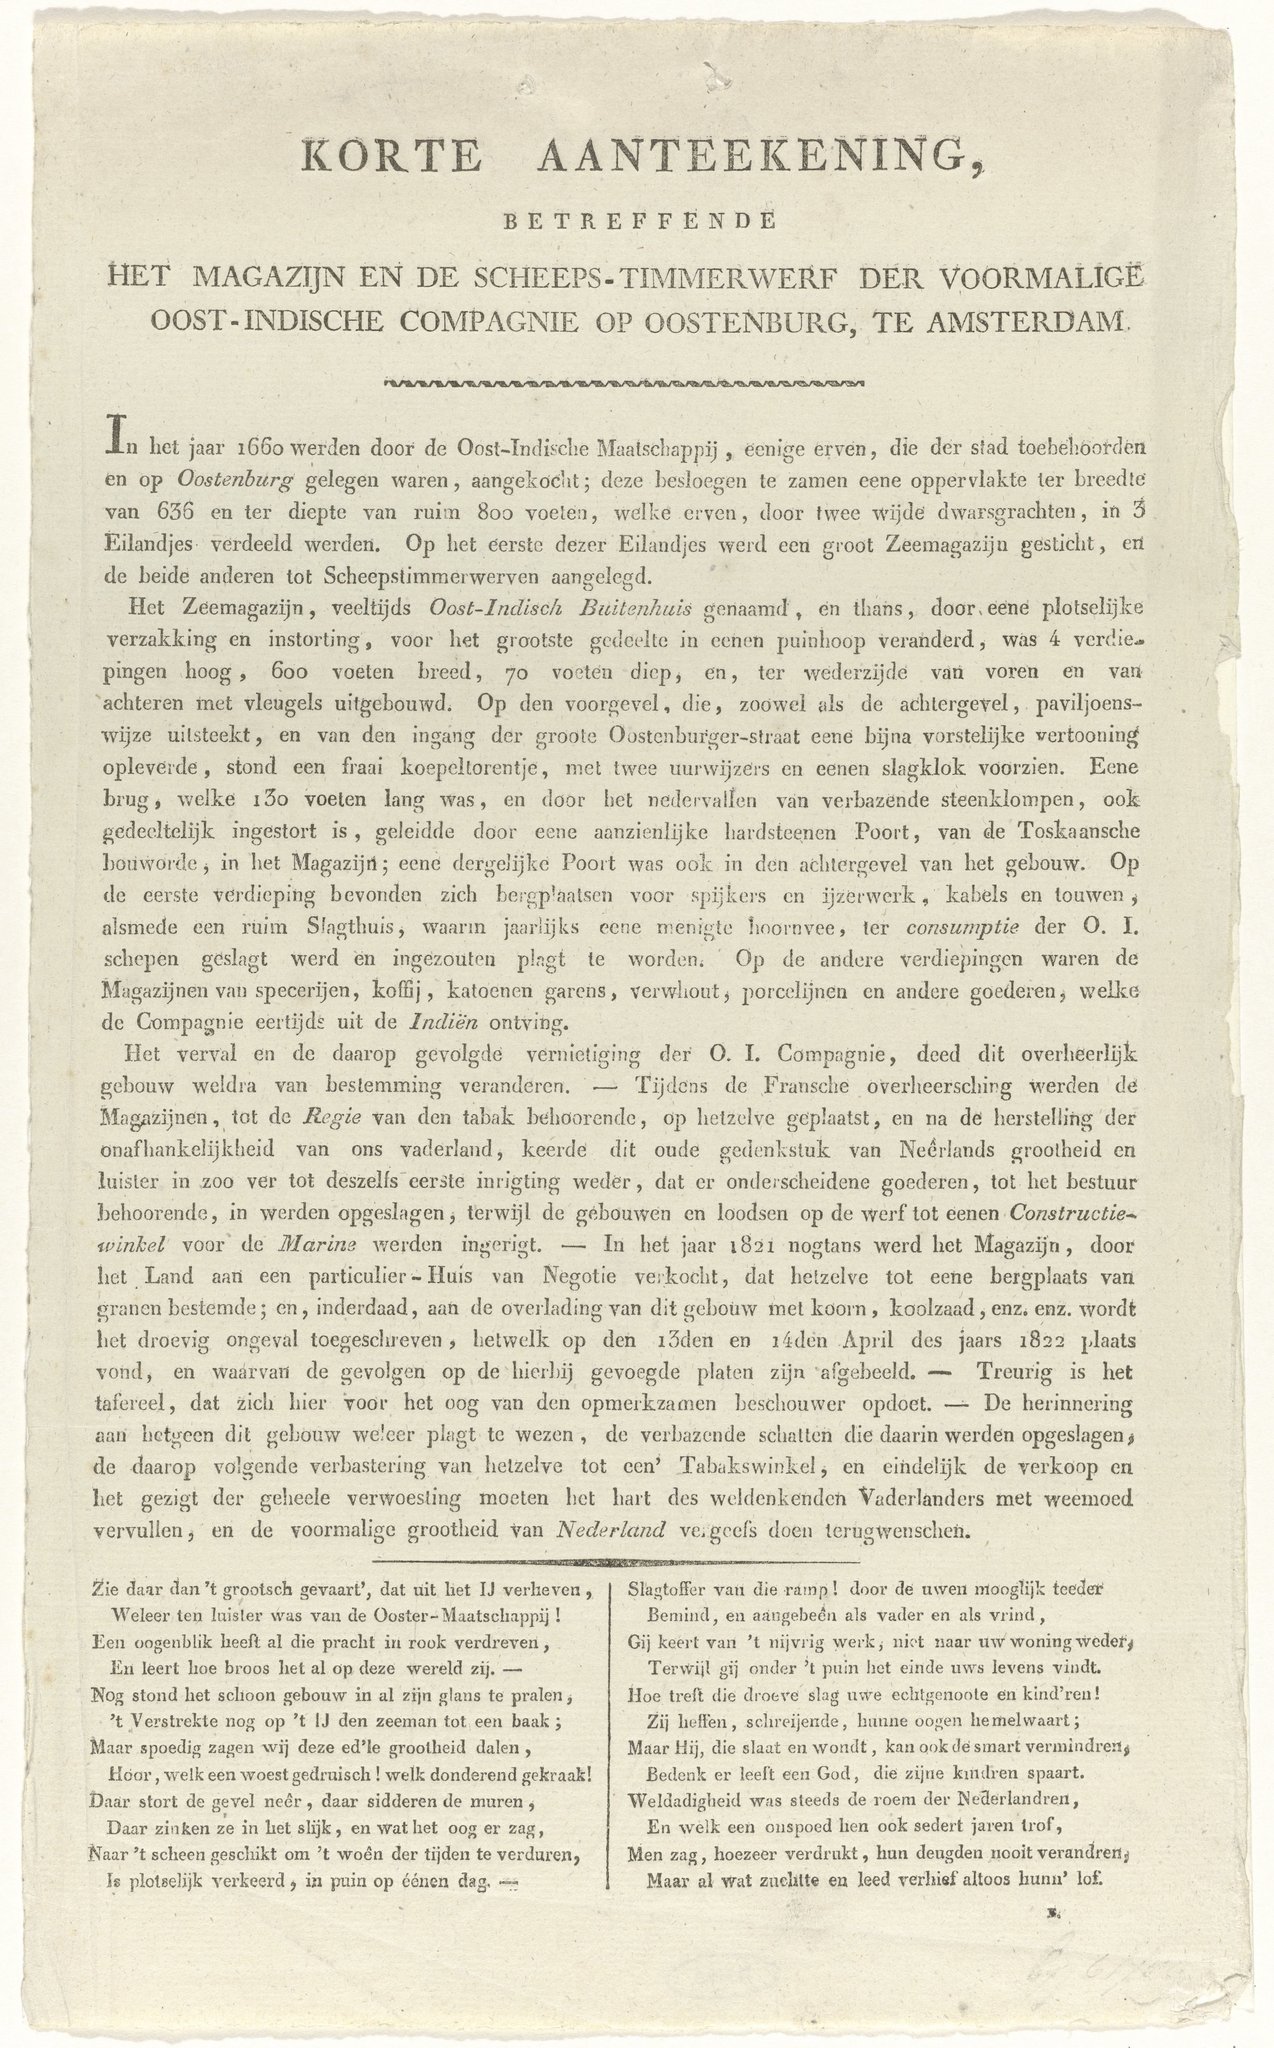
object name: text sheet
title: Historie van het Oost-Indisch Zeemagazijn, 1822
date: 1822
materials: paper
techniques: letterpress printing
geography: amsterdam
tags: oost-indisch zeemagazijn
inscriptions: collector's mark: Lugt 2228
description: Blad met een tekst over de geschiedenis van het Oost-Indisch Zeemagazijn te Amsterdam, tot en met de instorting op 13-14 april 1822. Onderaan een vers in twee kolommen.